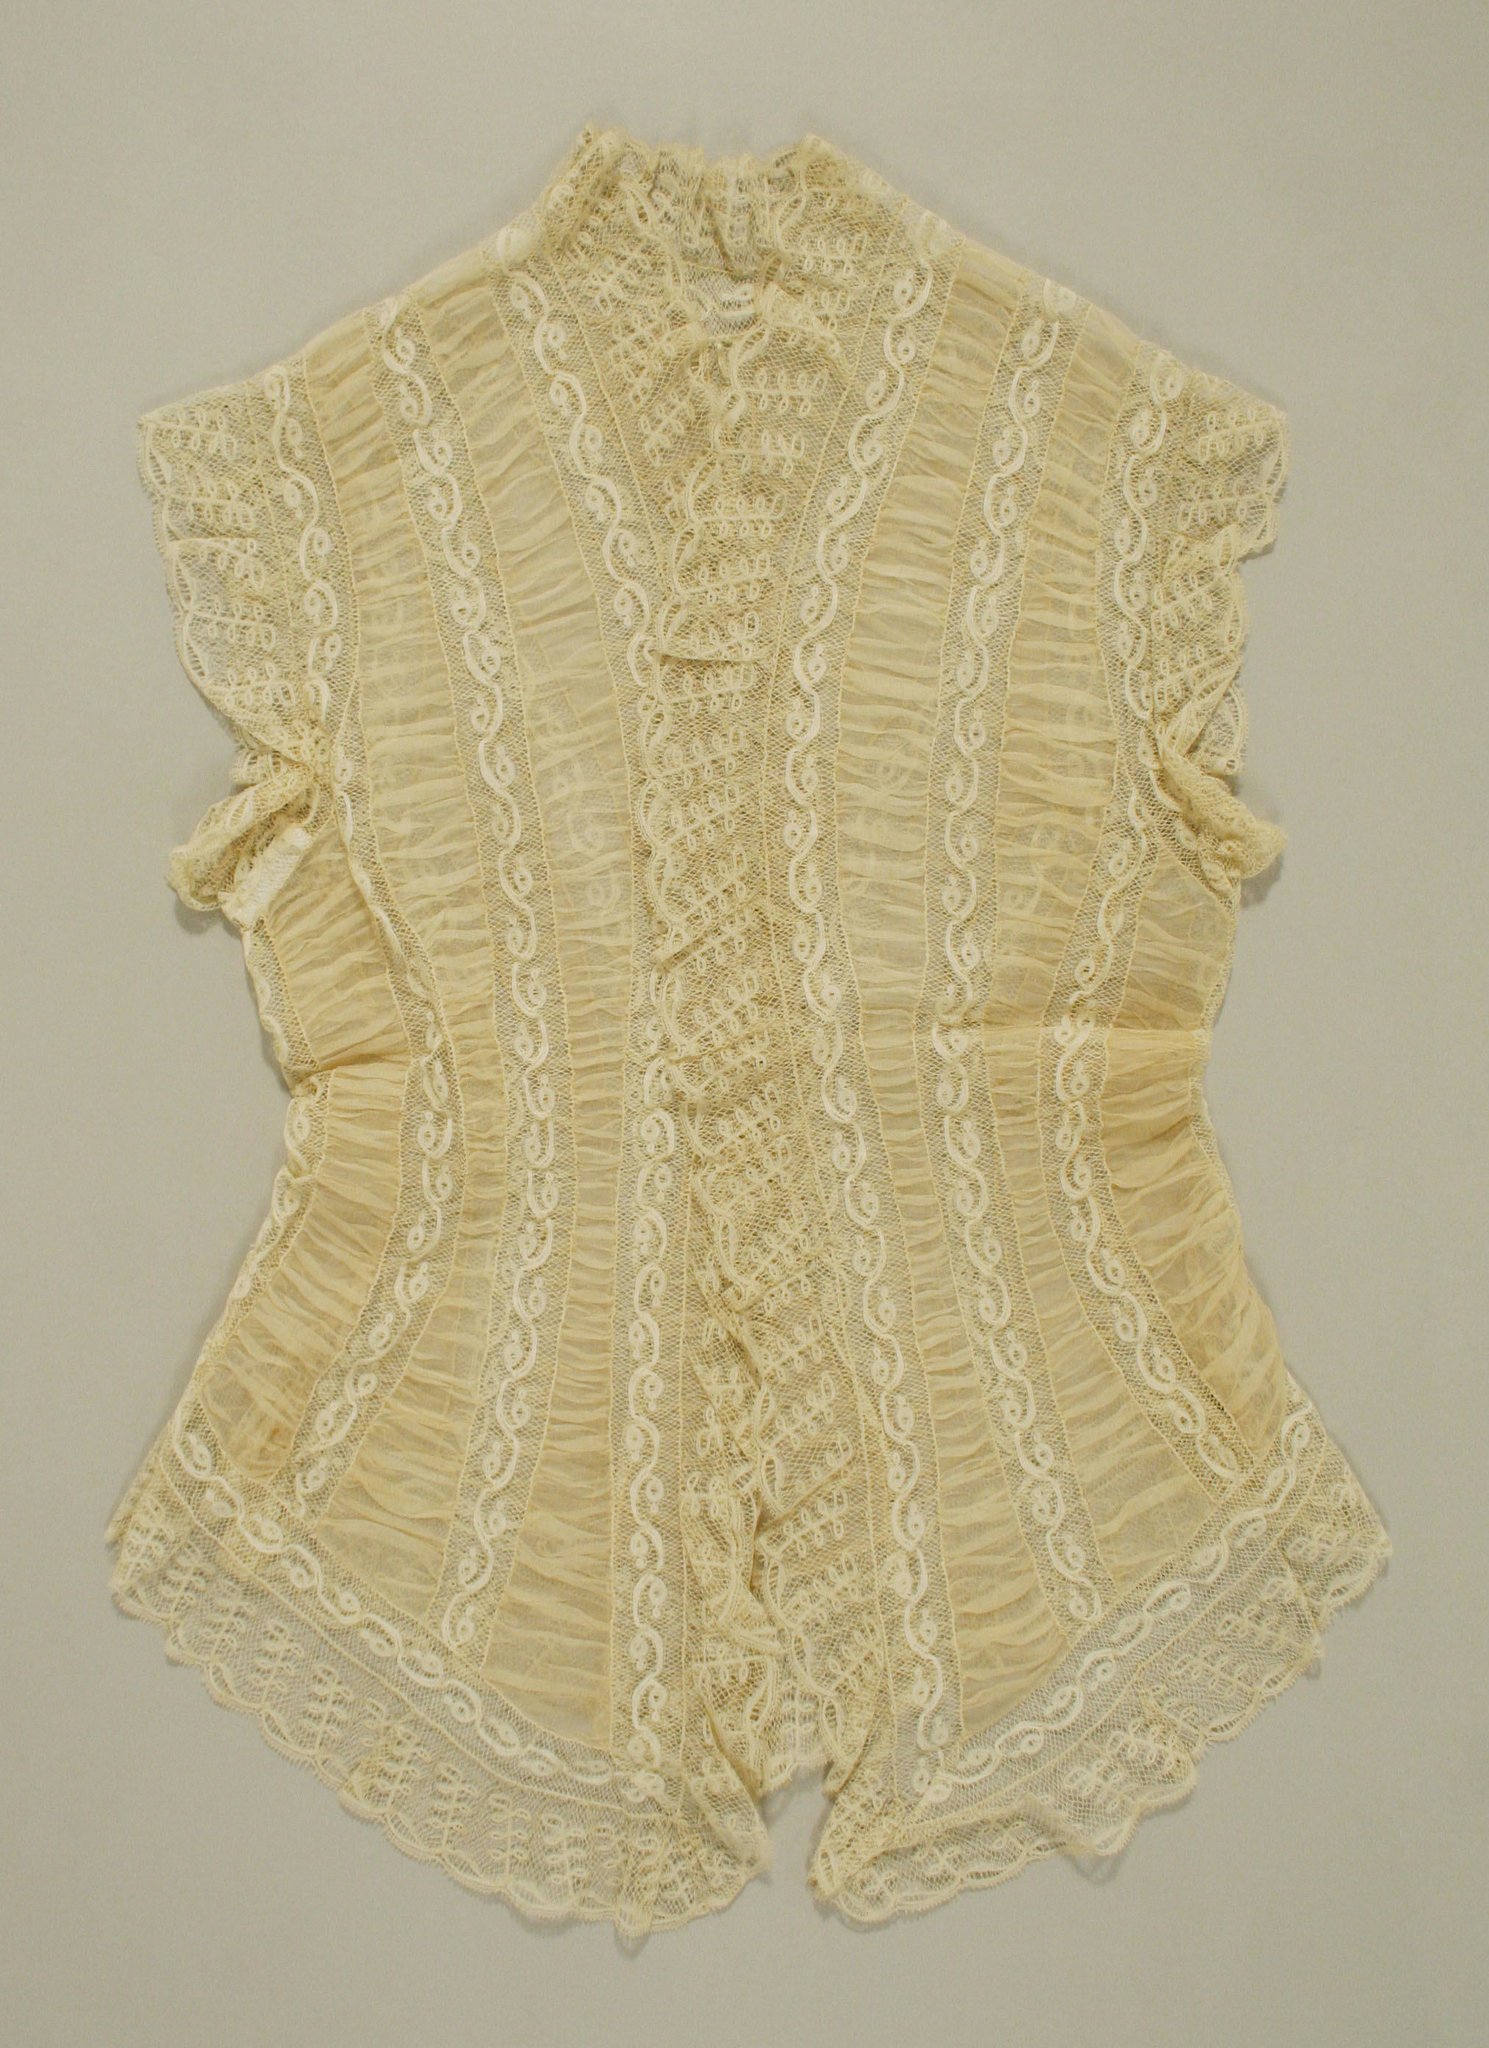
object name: basque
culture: french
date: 1870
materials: cotton